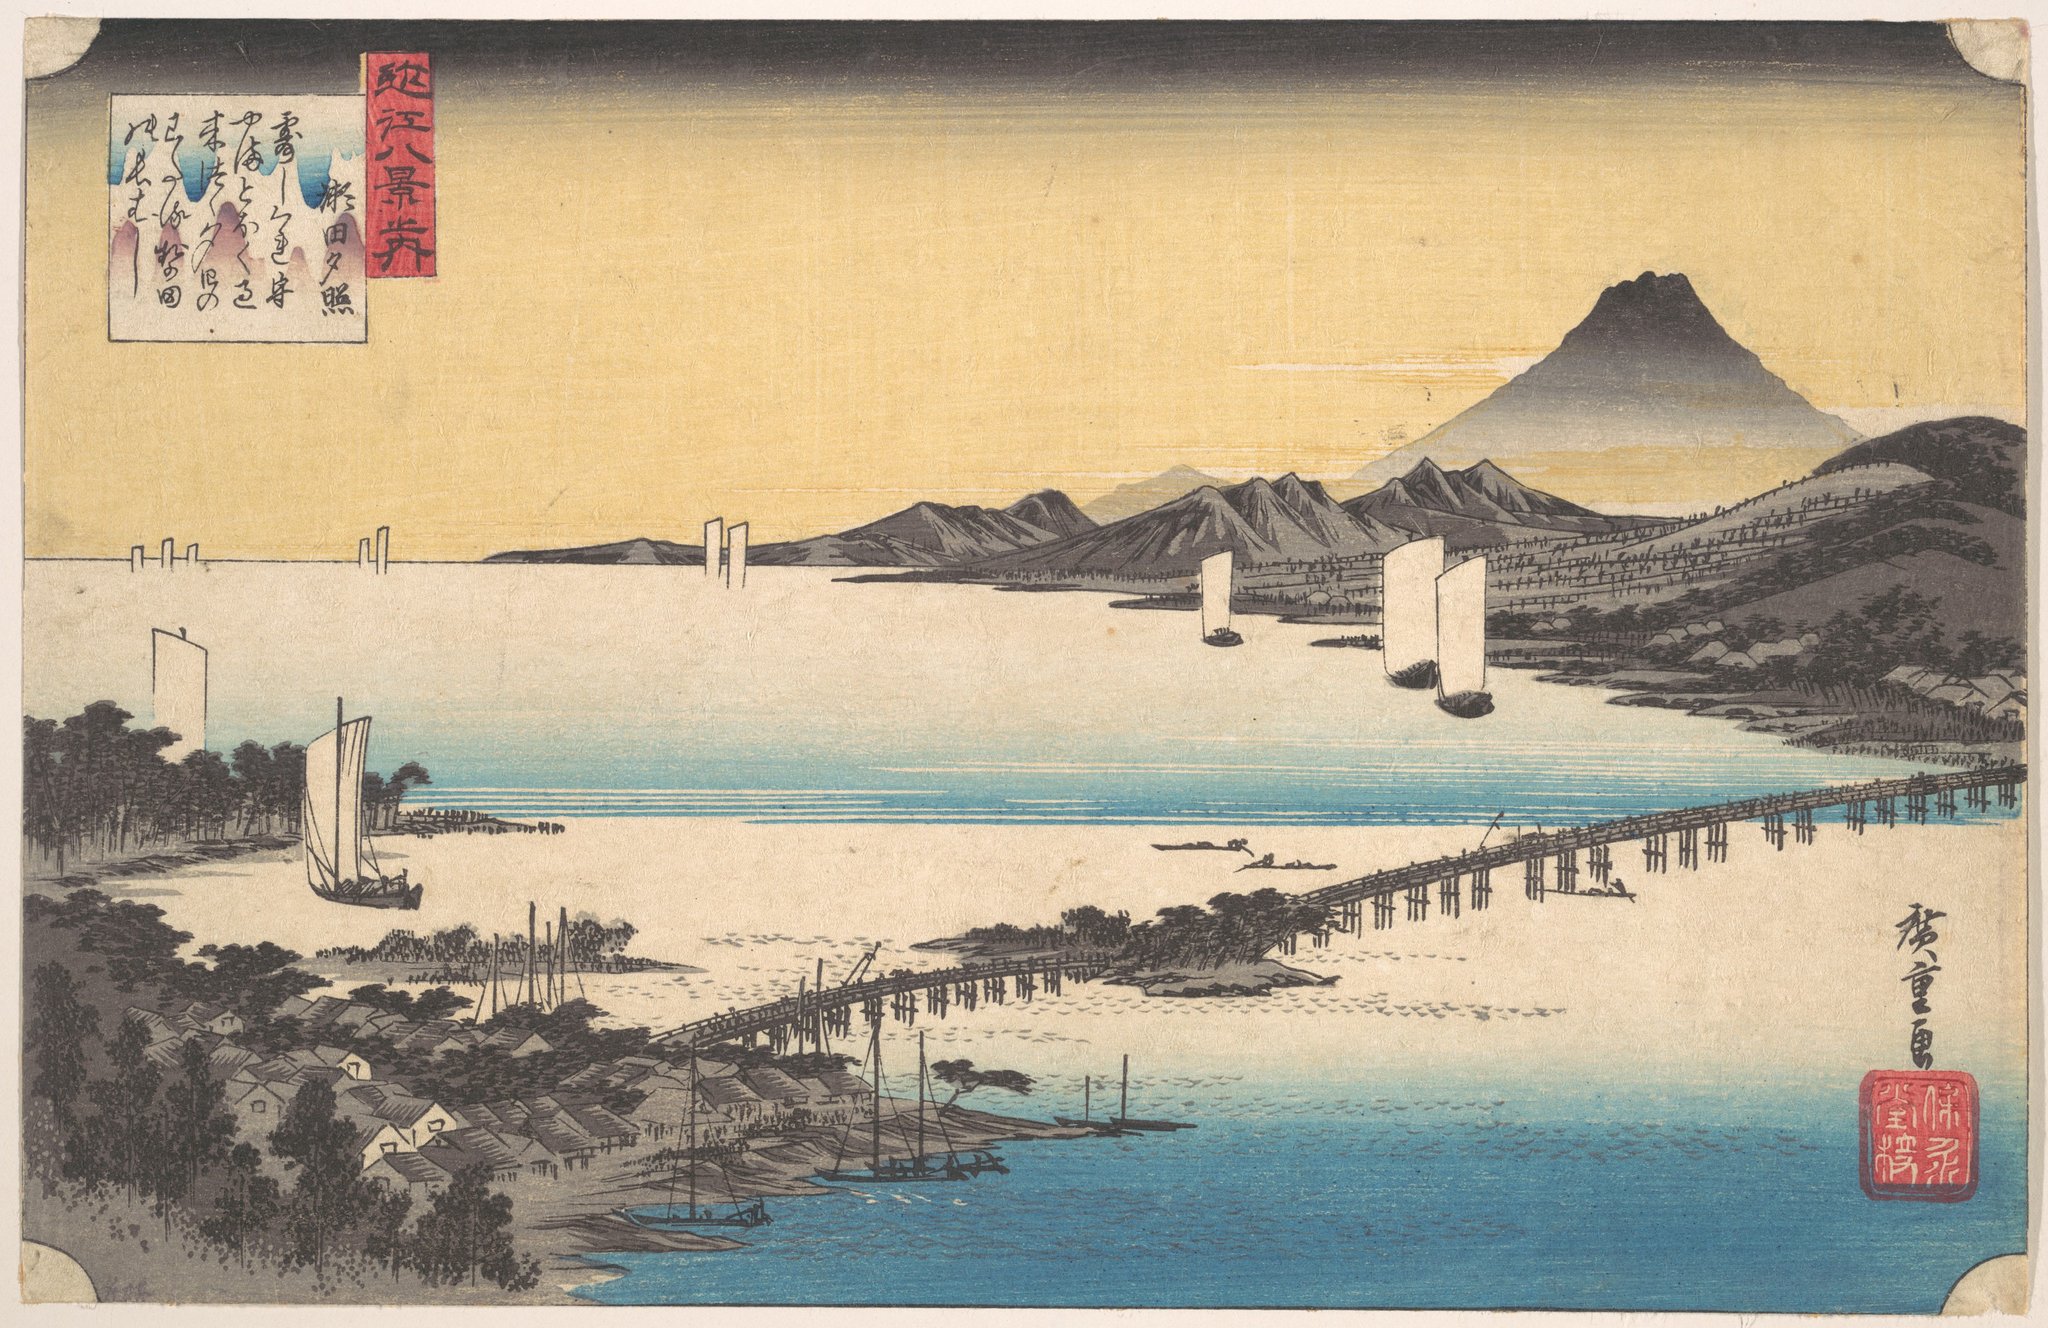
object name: print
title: Sunset at Seta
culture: japanese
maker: utagawa hiroshige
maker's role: artist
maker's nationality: japanese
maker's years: 1797-1858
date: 1797-1858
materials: ink, paper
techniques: woodblock print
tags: bridges,mountains,landscapes,boats